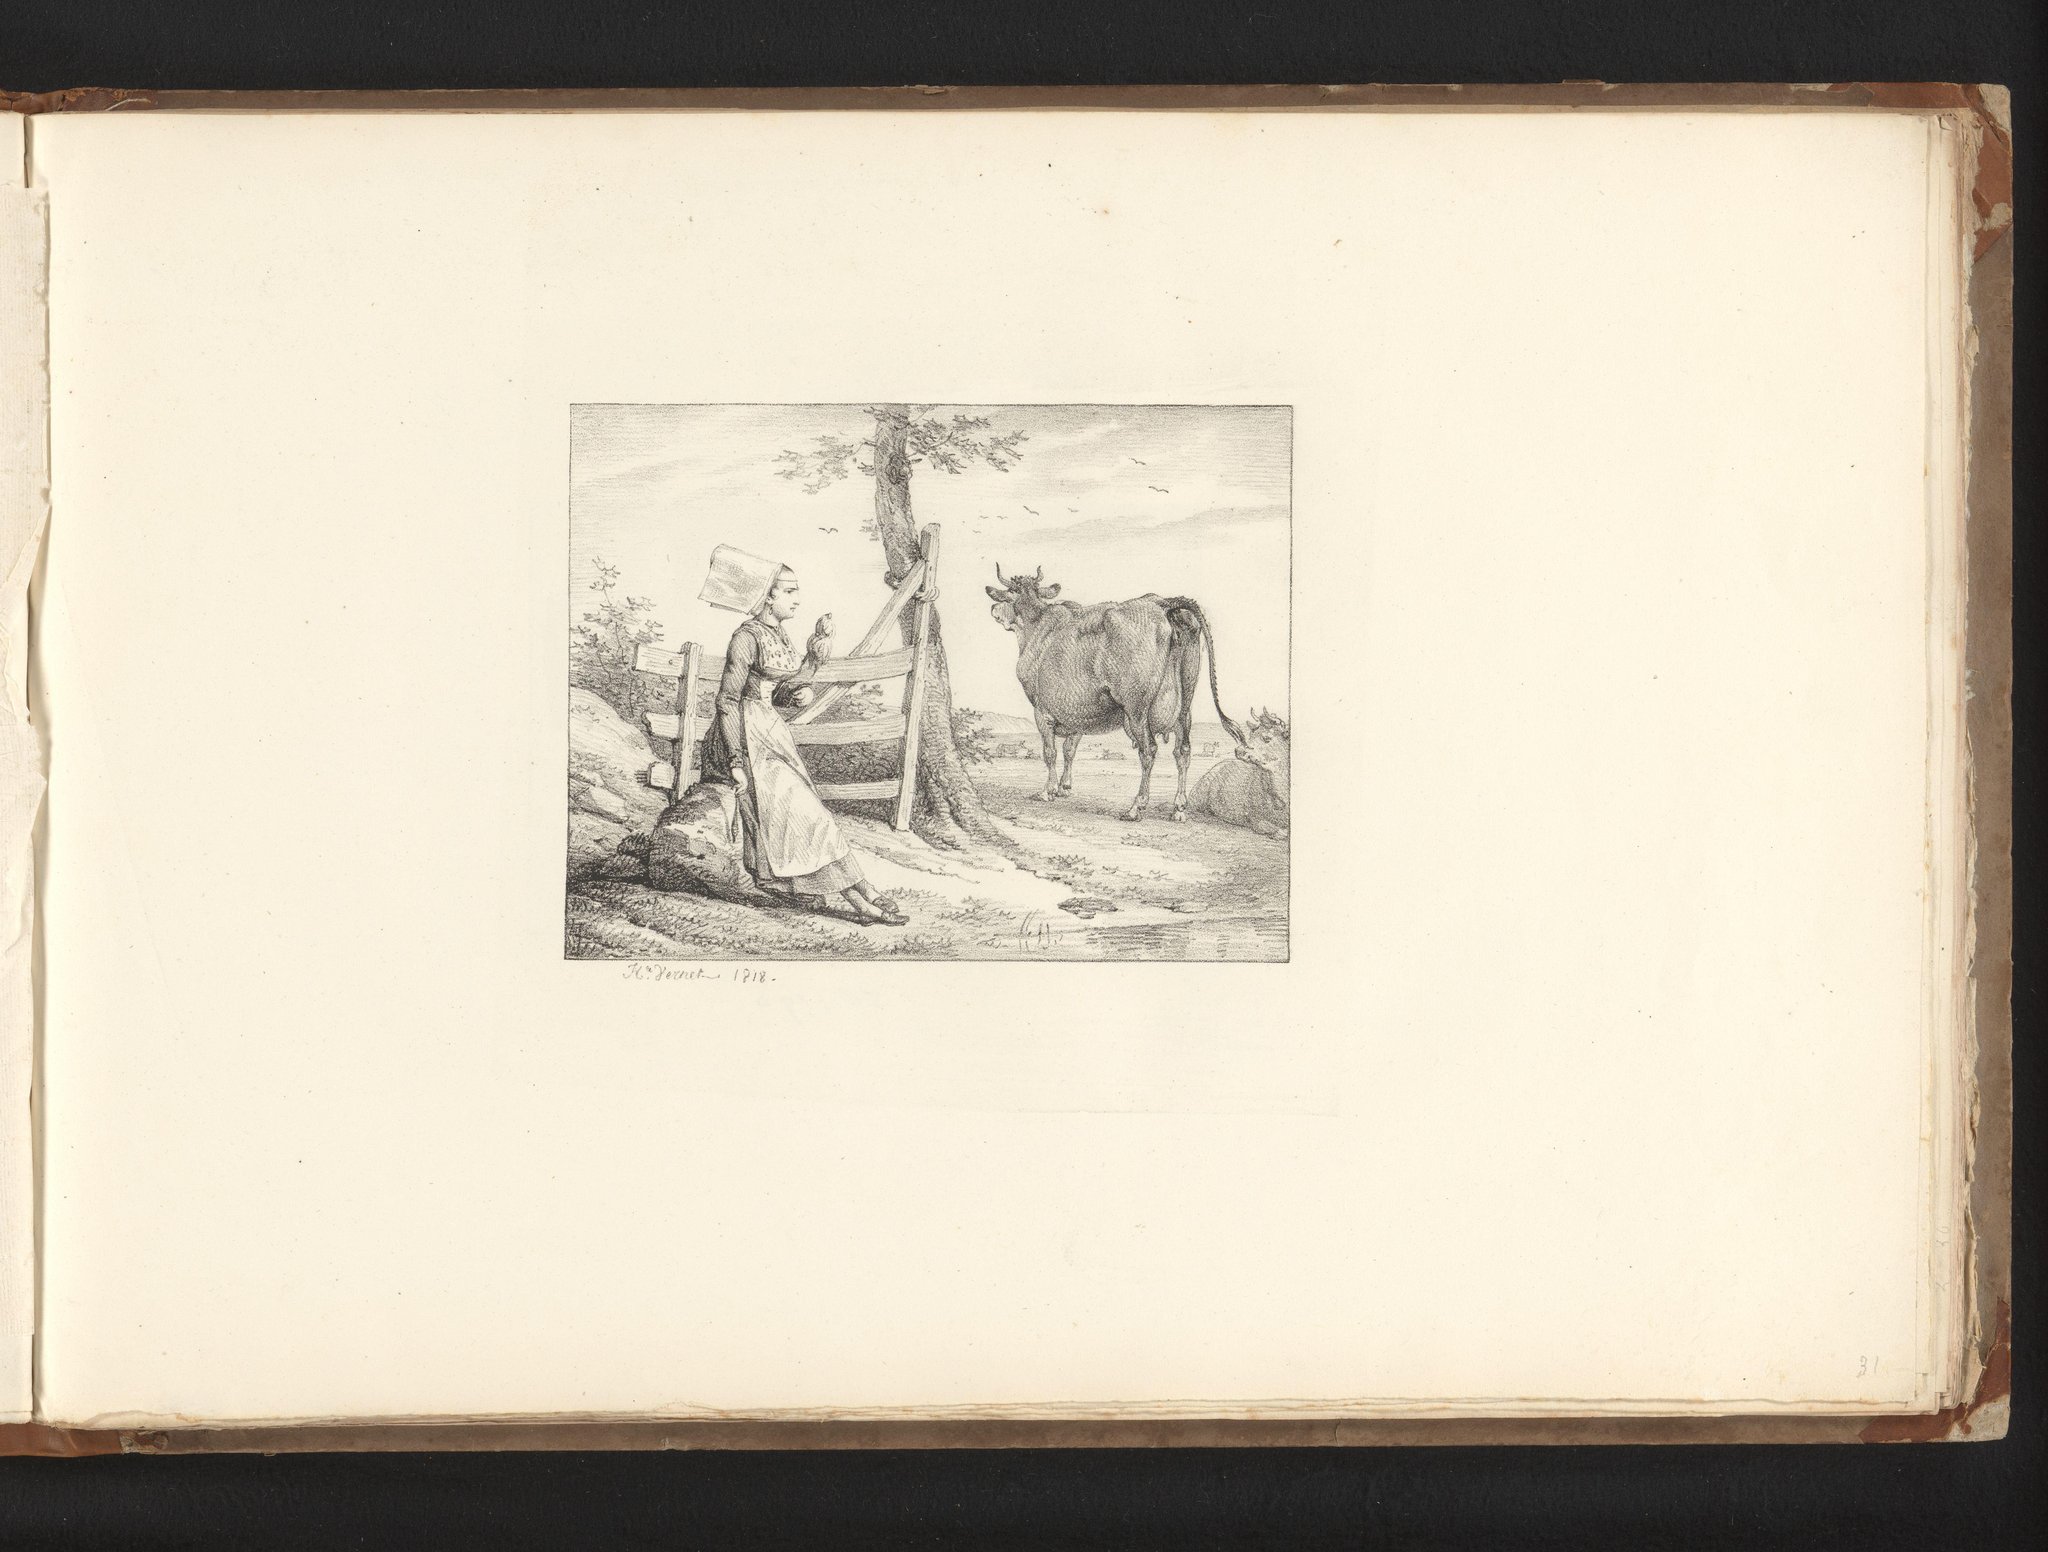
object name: print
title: Serie lithografieën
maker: horace vernet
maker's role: draughtsman, painter, print maker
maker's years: 1789-1863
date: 1818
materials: paper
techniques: lithograph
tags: cow, spindle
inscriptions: date